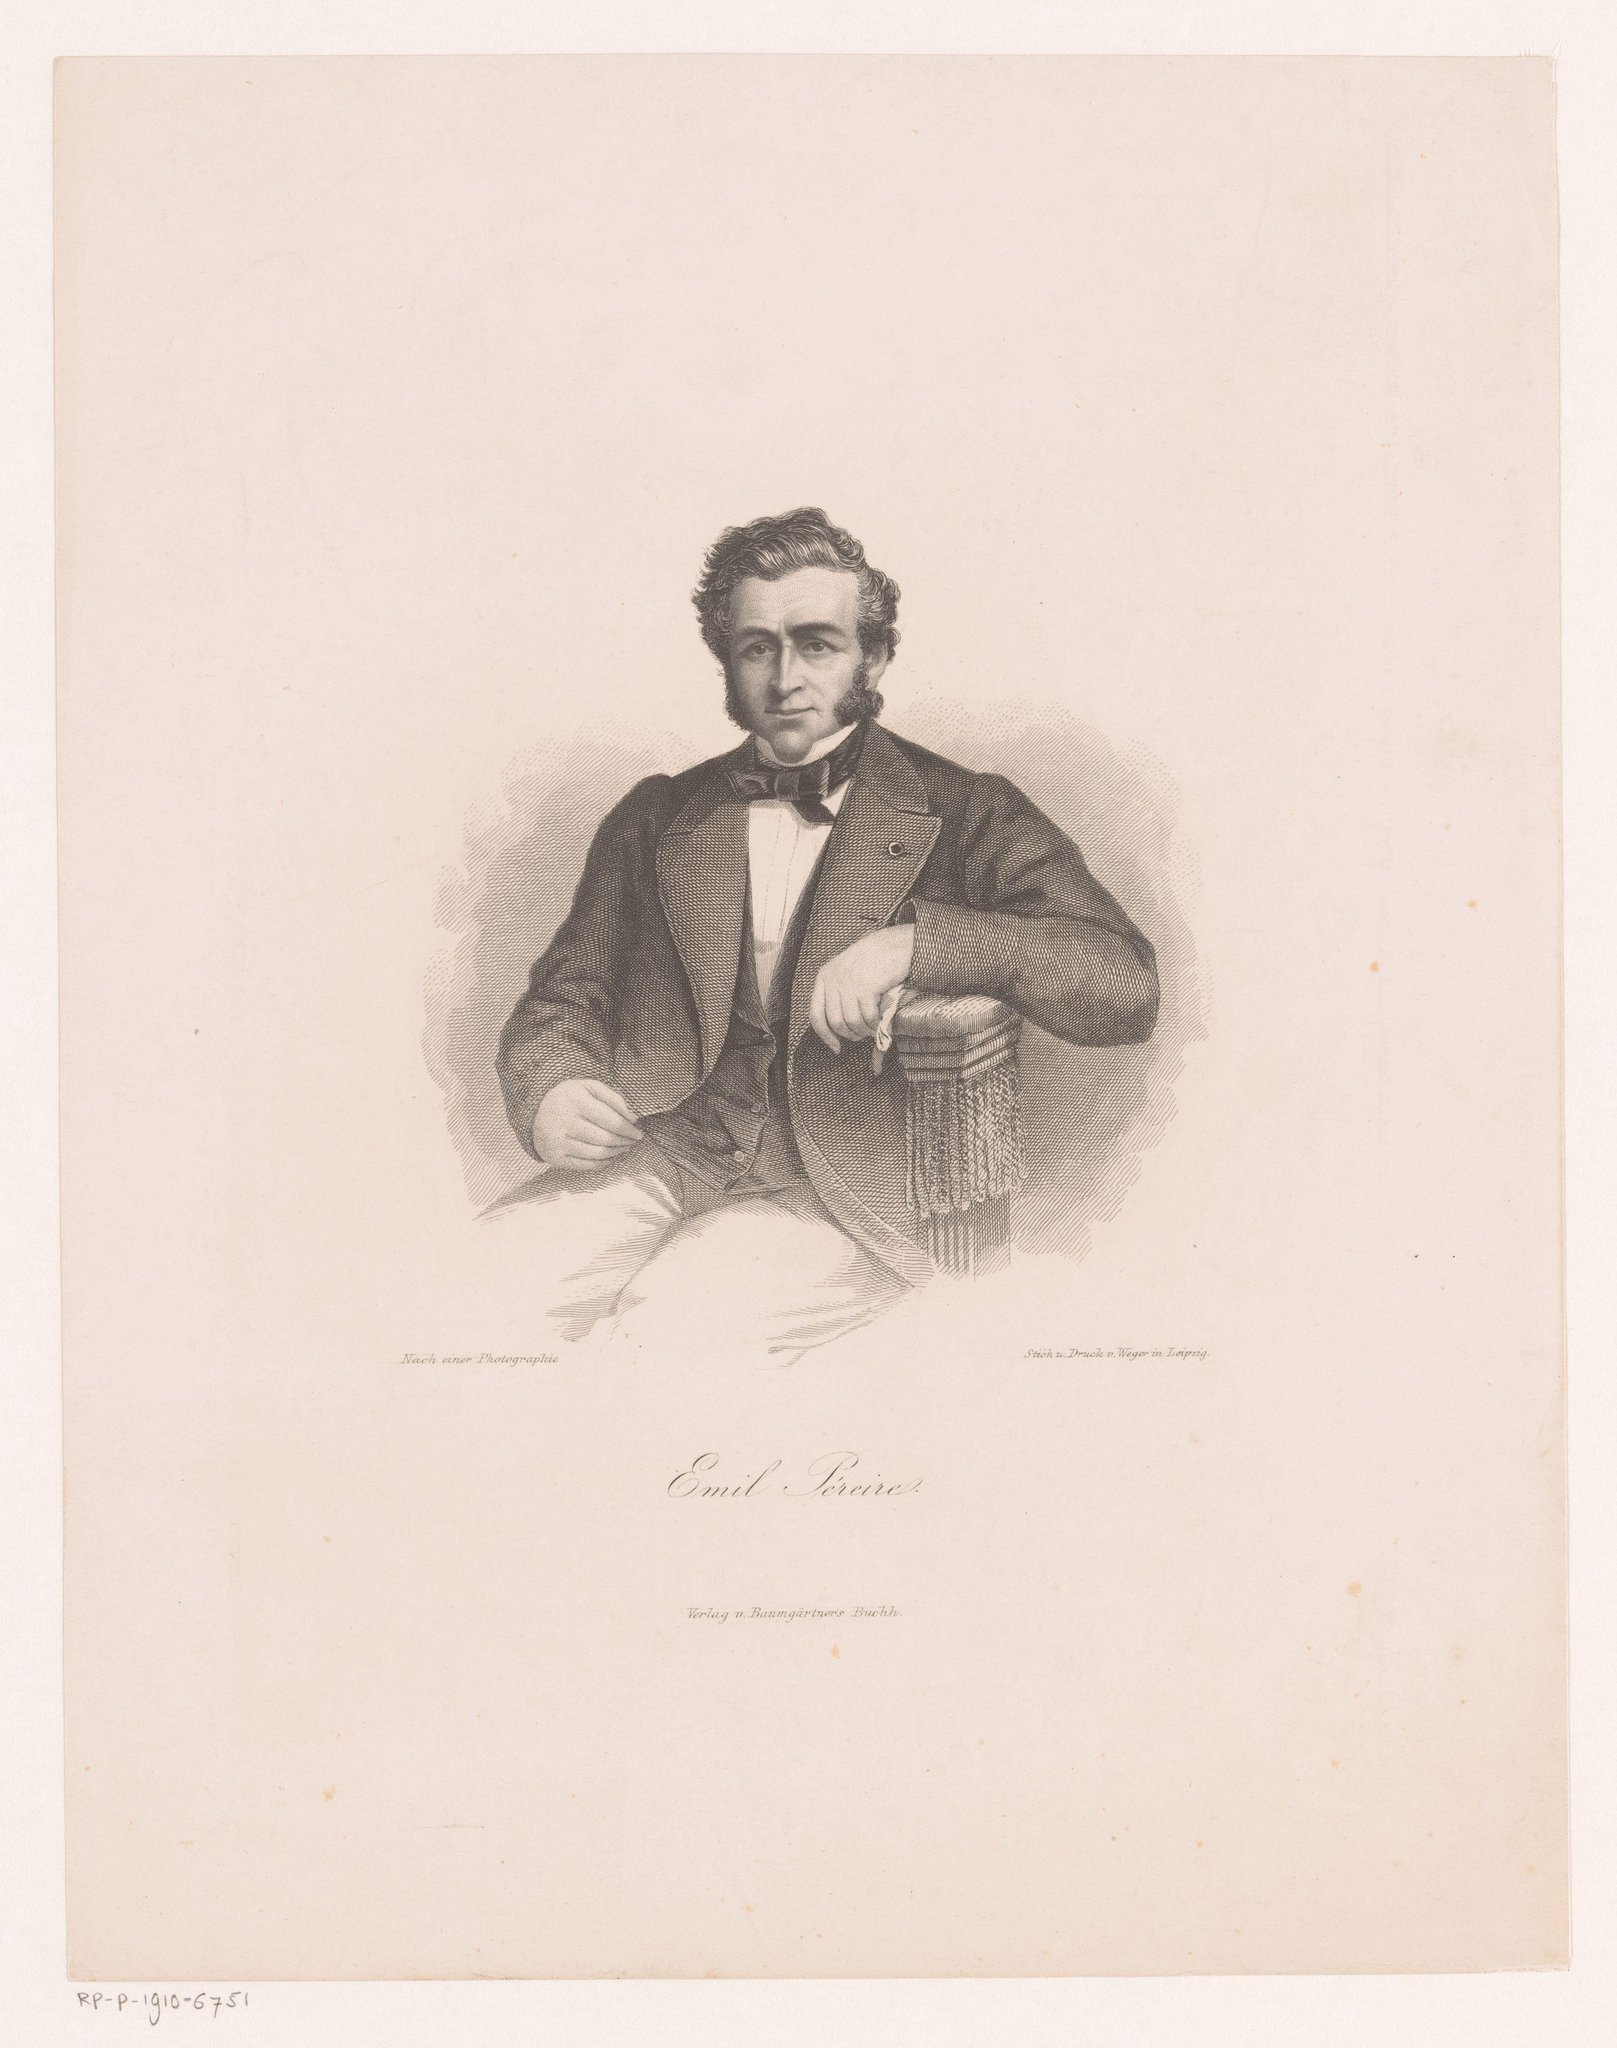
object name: print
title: Portret van Emile Péreire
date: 1849-1892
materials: paper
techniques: engraving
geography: leipzig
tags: paris, politician, historical persons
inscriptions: collector's mark: Lugt 2228